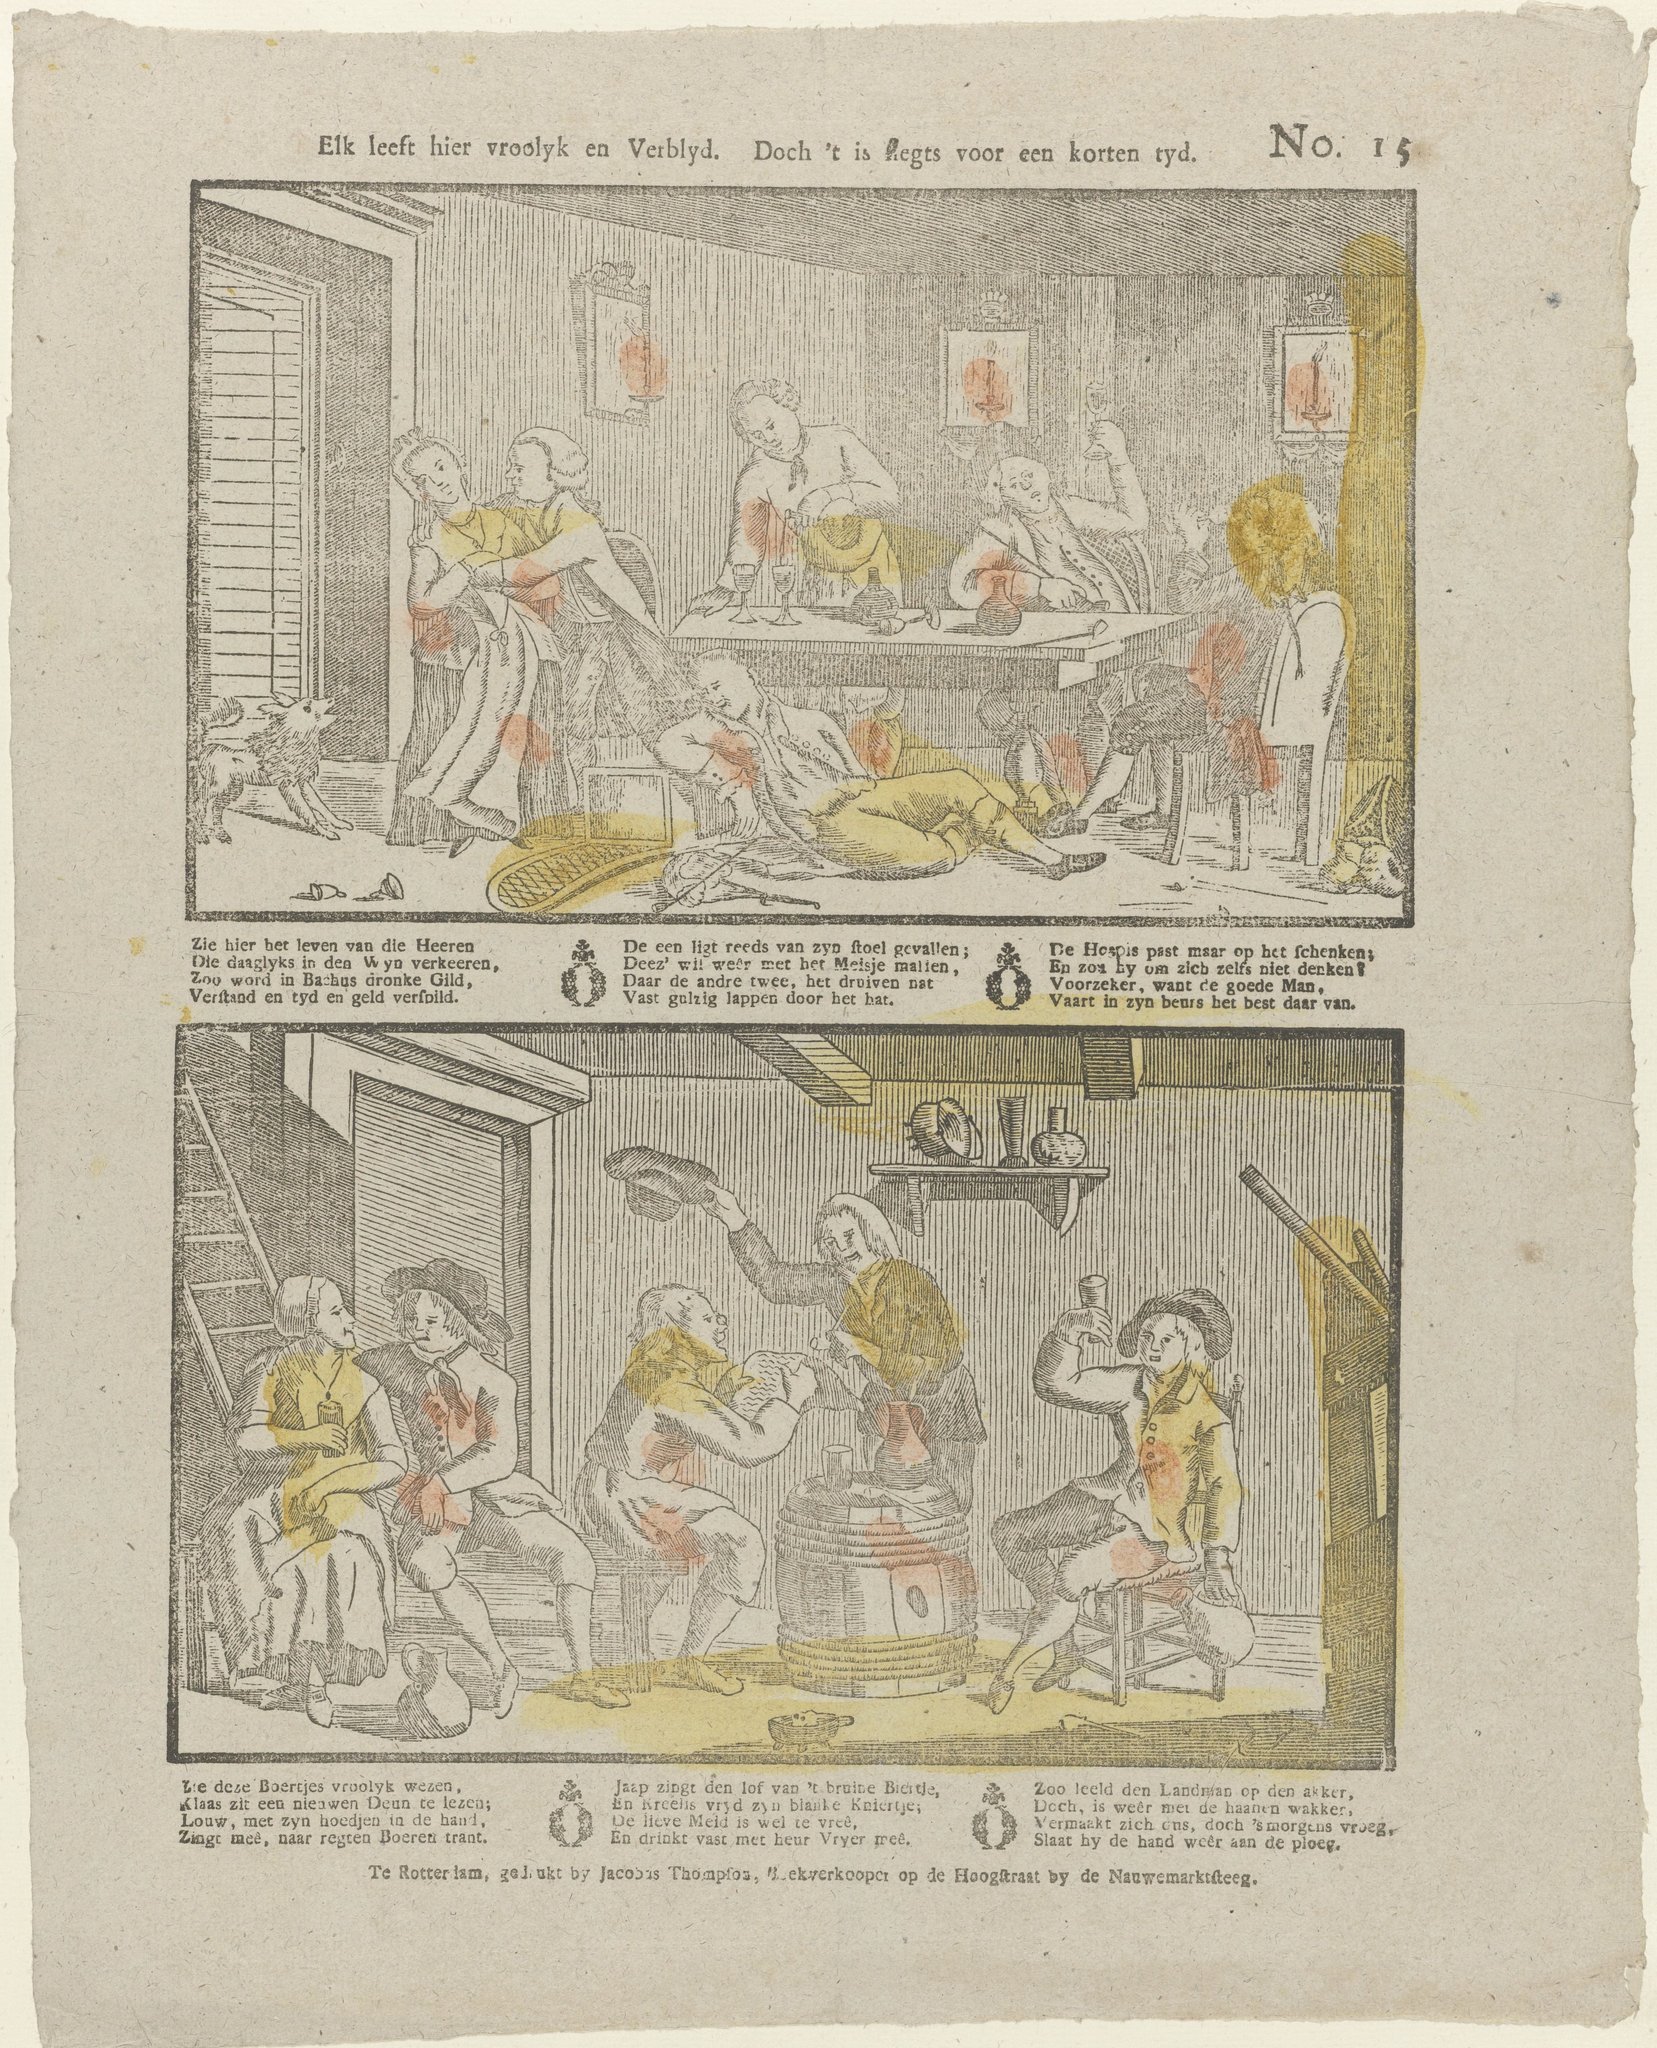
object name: popular print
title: Elk leeft hier vroolyk en verblyd. Doch 't is slegts voor een korten tyd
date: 1791-1812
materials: paper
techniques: colour, letterpress printing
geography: rotterdam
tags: stimulating drinks, drunkard, drunkenness, alcoholic drinks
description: Blad met 2 voorstellingen van mensen die drinken. Boven: een gezelschap heren drinkend rond een tafel. Onder: een gezelschap boeren drinkend rond een ton. Onder elke afbeelding een twaalfregelig vers in drie kolommen. Genummerd rechtsboven: No. 15.